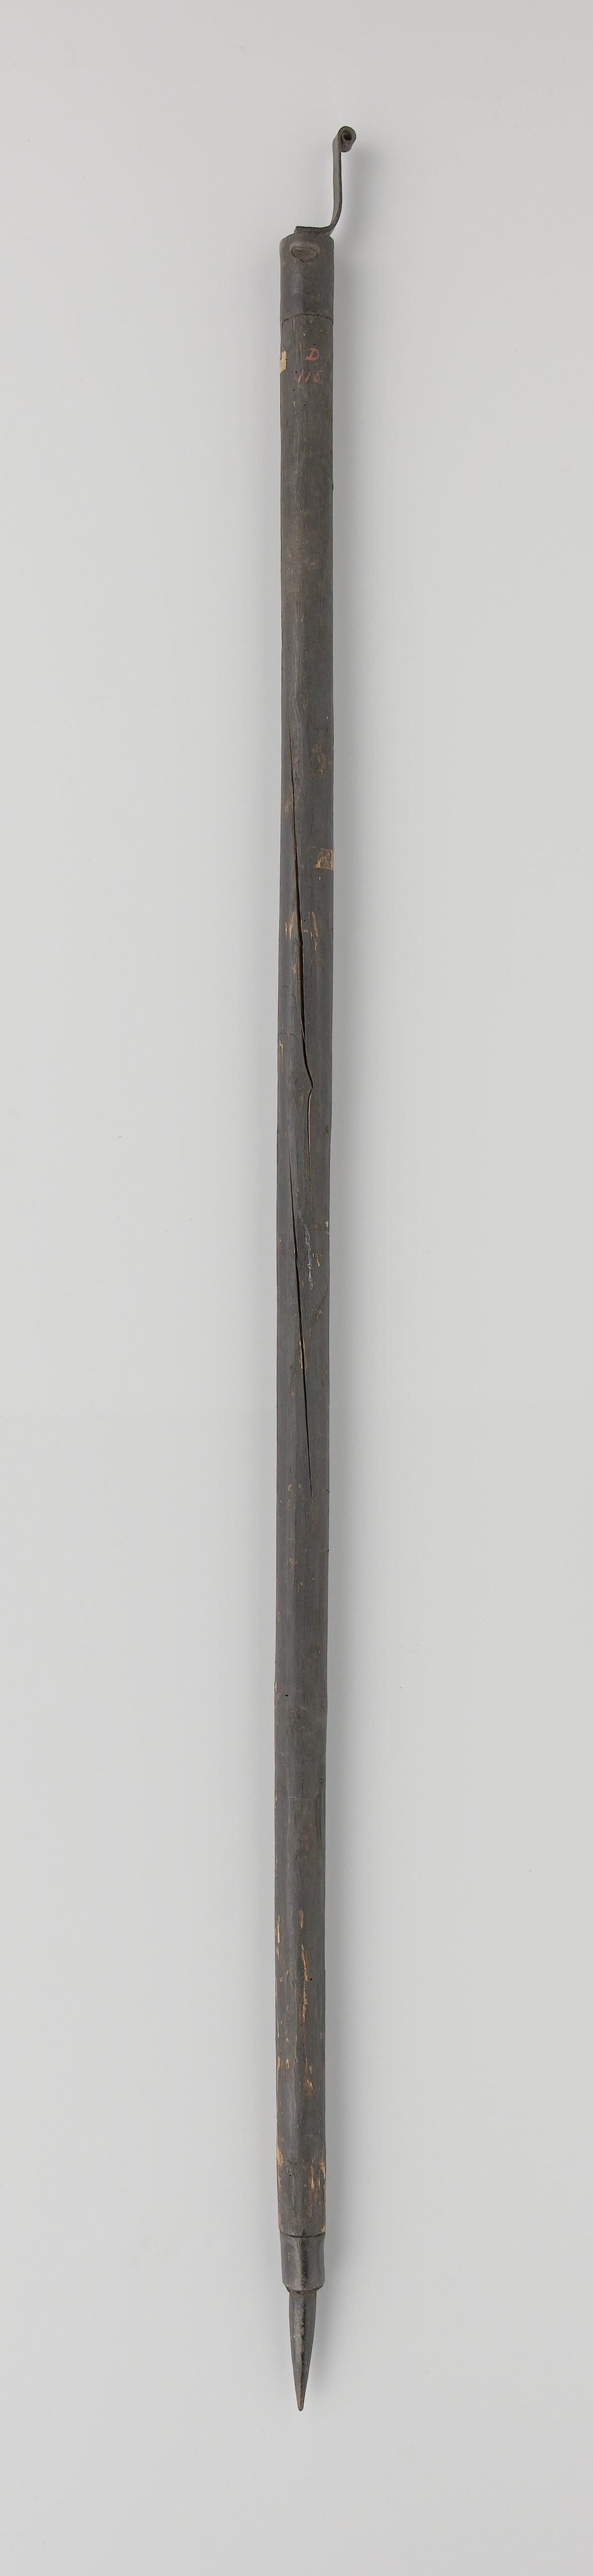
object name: furket, musketvork, forket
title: Furket, defect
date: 1499-1799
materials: iron, wood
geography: low countries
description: Furket of musketvork waarvan de linkervork is afgebroken. De schacht is van hout welke zwart is geverfd met aan het uiteinde een ijzeren punt.